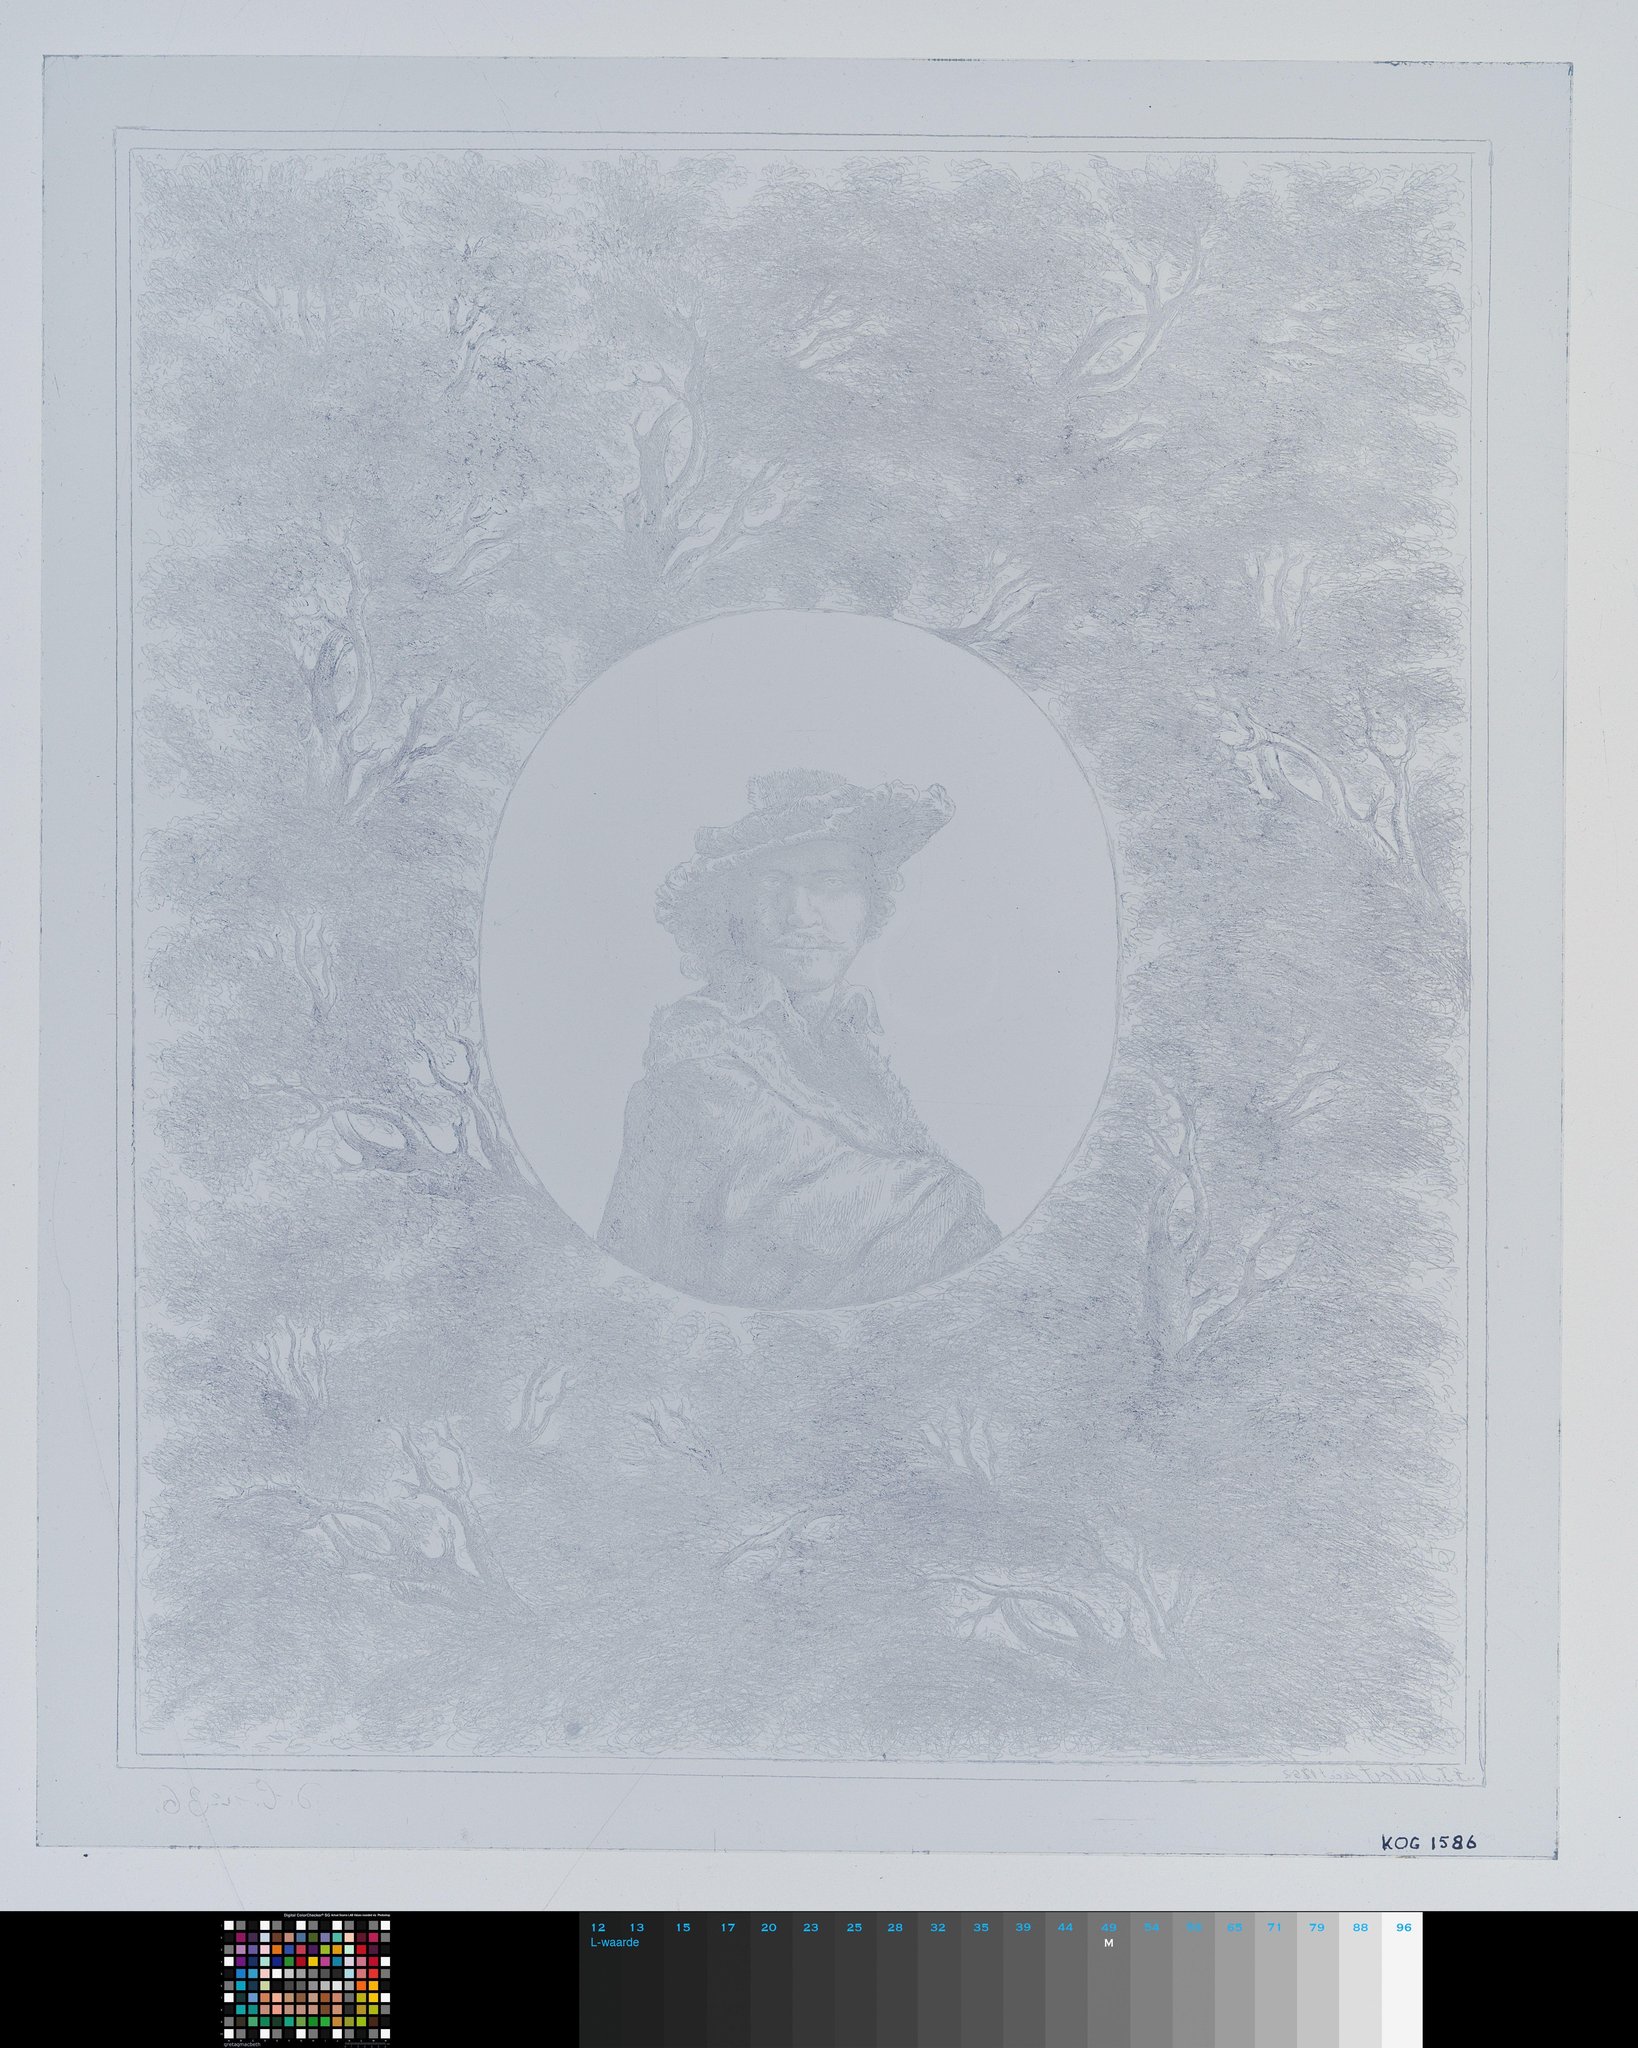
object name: light window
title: Ruit met een portret van Rembrandt omgeven door boomtakken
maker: servatius johannes melort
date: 1852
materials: glass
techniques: diamond point engraving, engraving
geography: netherlands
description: Panel. Glass, diamond-point and stipple engraving with a portrait of Rembrandt van Rijn. Netherlands, 1852, by Servatius Johannes Melort.